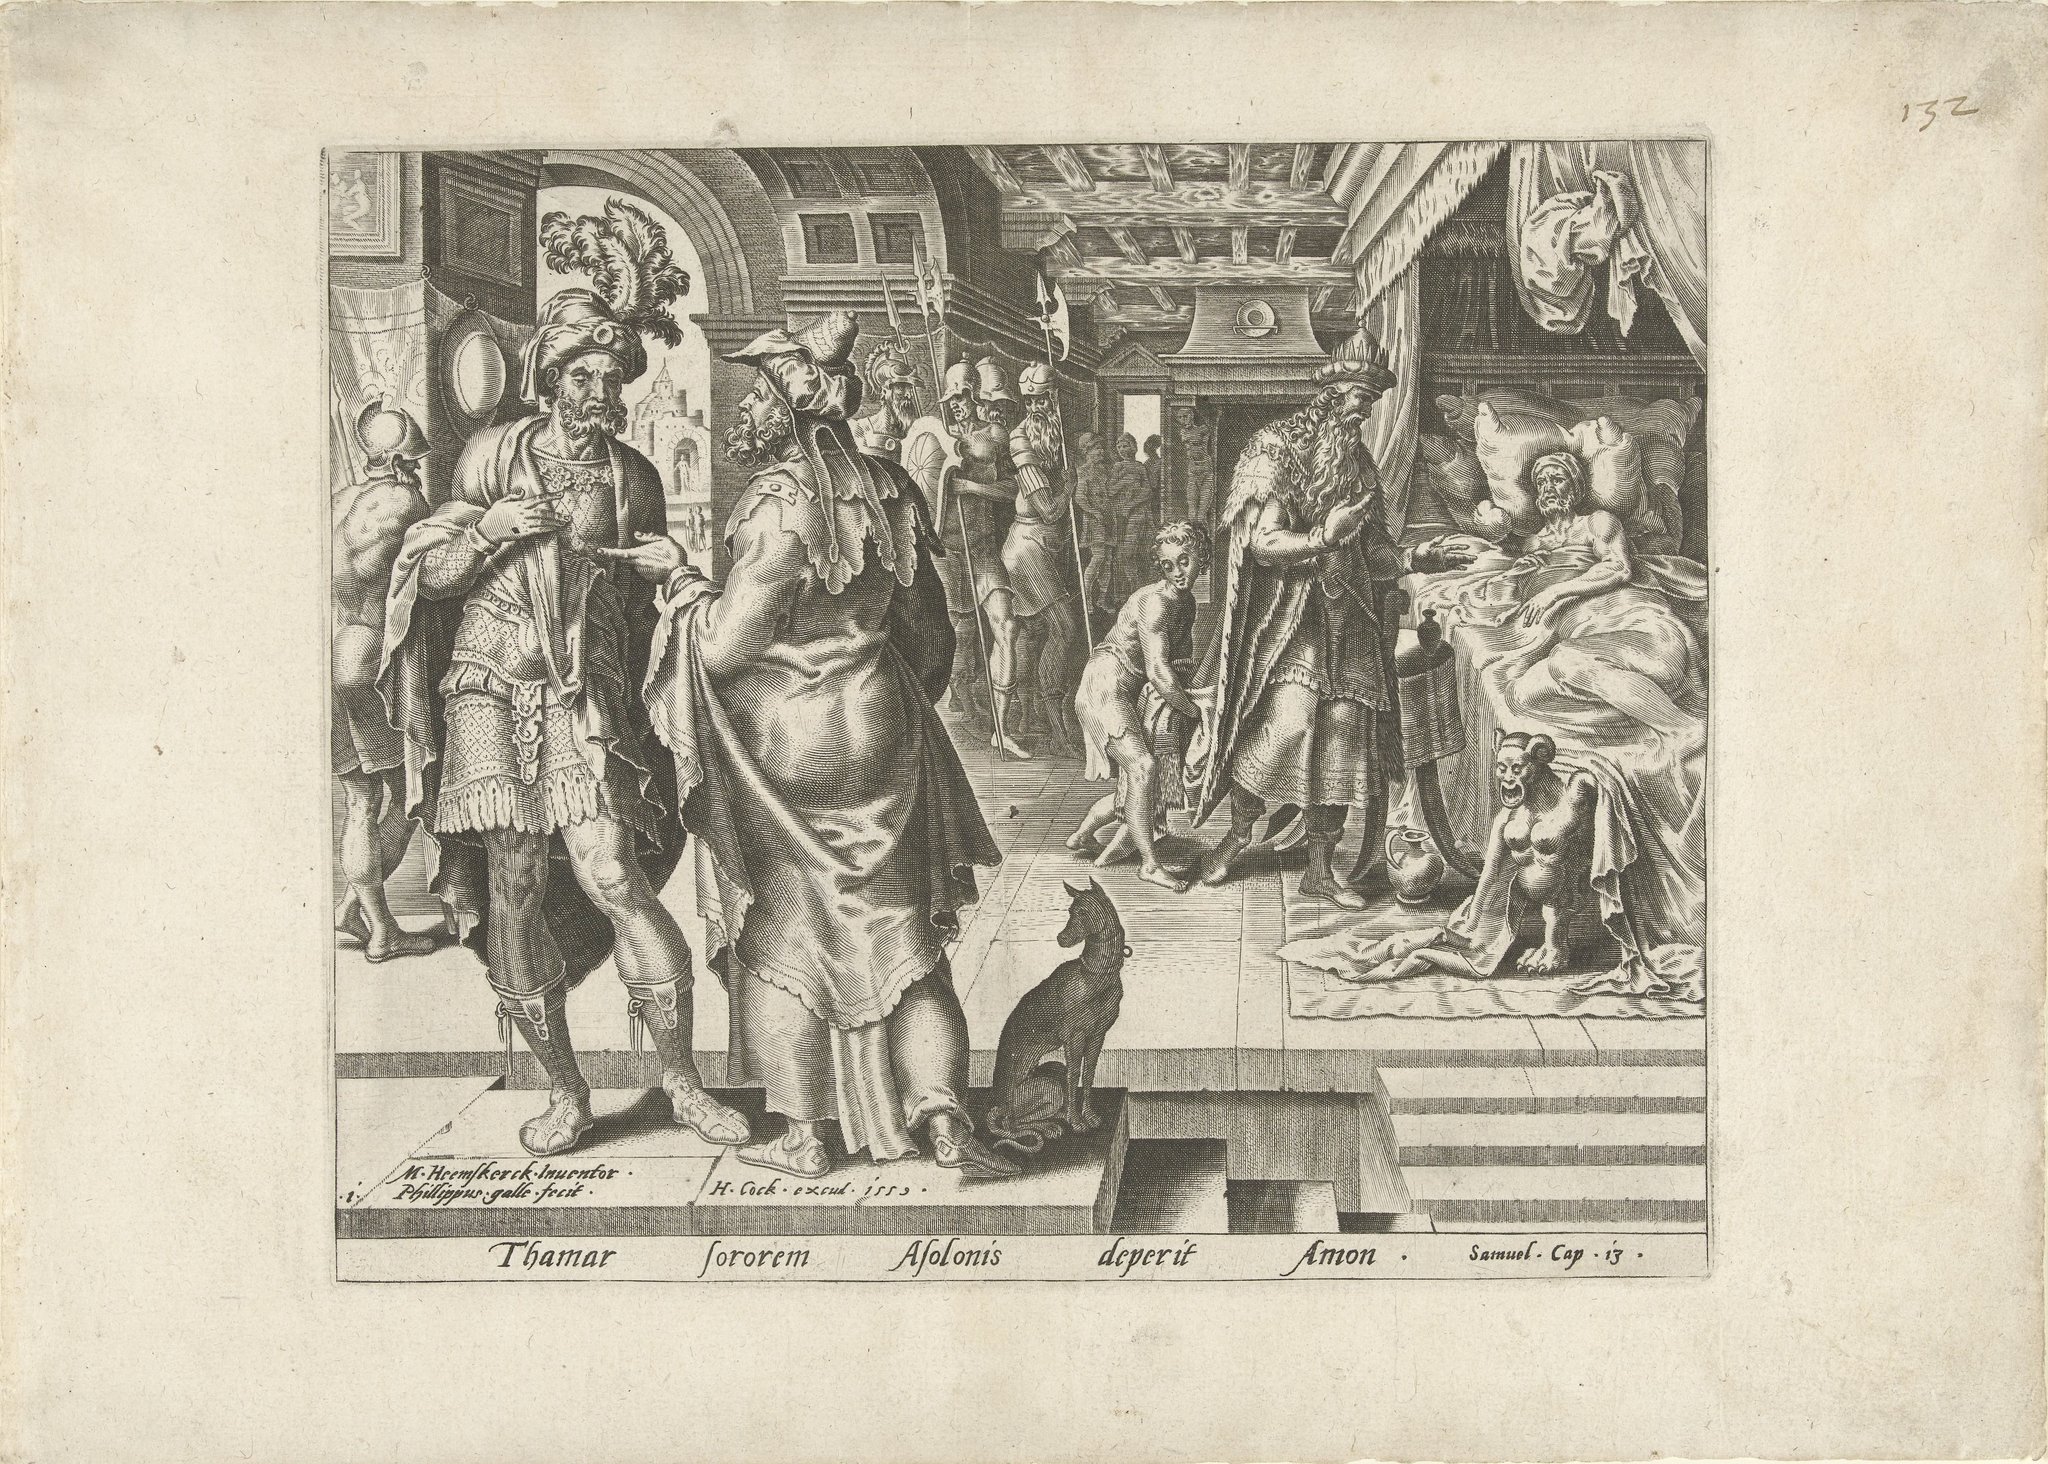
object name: print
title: Jonadab adviseert Amnon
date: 1559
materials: paper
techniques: engraving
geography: antwerp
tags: jonadab gives counsel to amnon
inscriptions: collector's mark: Lugt 2228, collector's mark: Lugt 2760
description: Jonadab adviseert zijn neef Amnon ziek op bed te gaan liggen en om Tamars aanwezigheid te vragen. Links voor: Jonadab en Amnon in gesprek. Rechts achter komt David zijn zoon Amnon die ziek op bed ligt opzoeken.